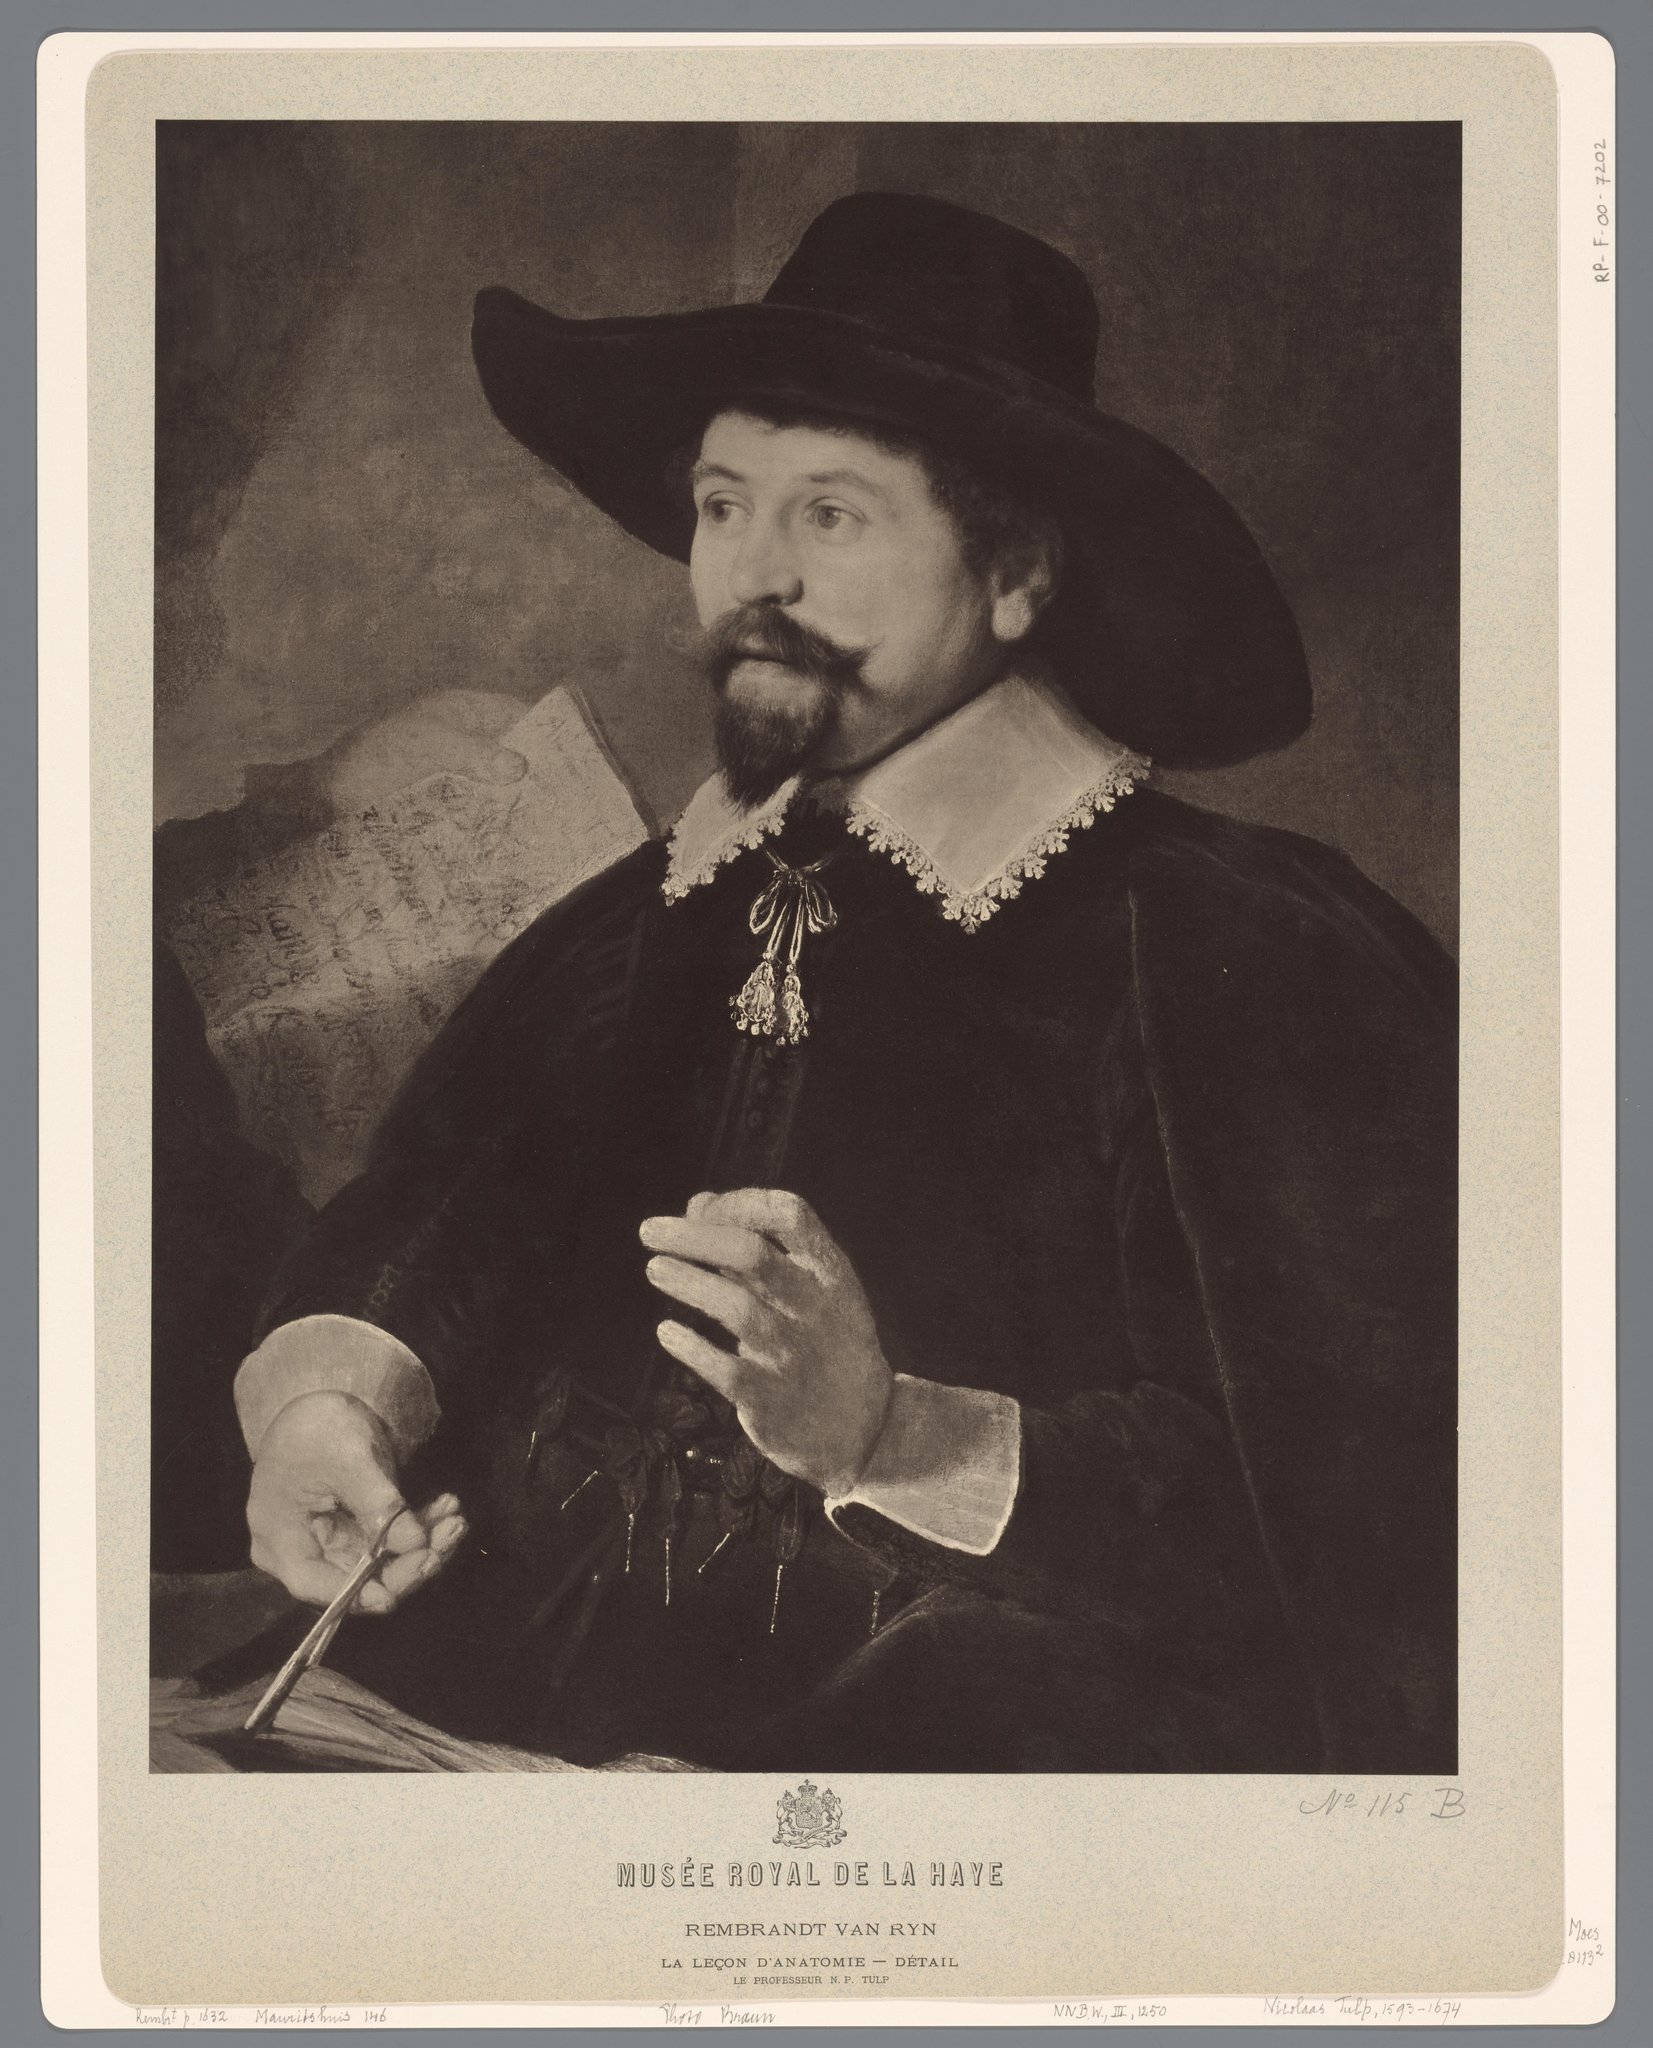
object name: photograph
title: Fotoreproductie van een detail van De anatomische les van Dr. Nicolaes Tulp door Rembrandt van Rijn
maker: rembrandt van rijn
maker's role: draughtsman, painter, print maker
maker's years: 1606-1669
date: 1880-1900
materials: cardboard, paper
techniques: carbon print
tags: amsterdam, the hague, mayor, physician, doctor, anatomy lesson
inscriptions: inscription: ‘Nicolaes Tulp, 1593-1674/ Rtp. Mauritshuis no.146 (1632)/ Moes 8113-2’, collector's mark: Lugt 2228, number: ‘No 115B’